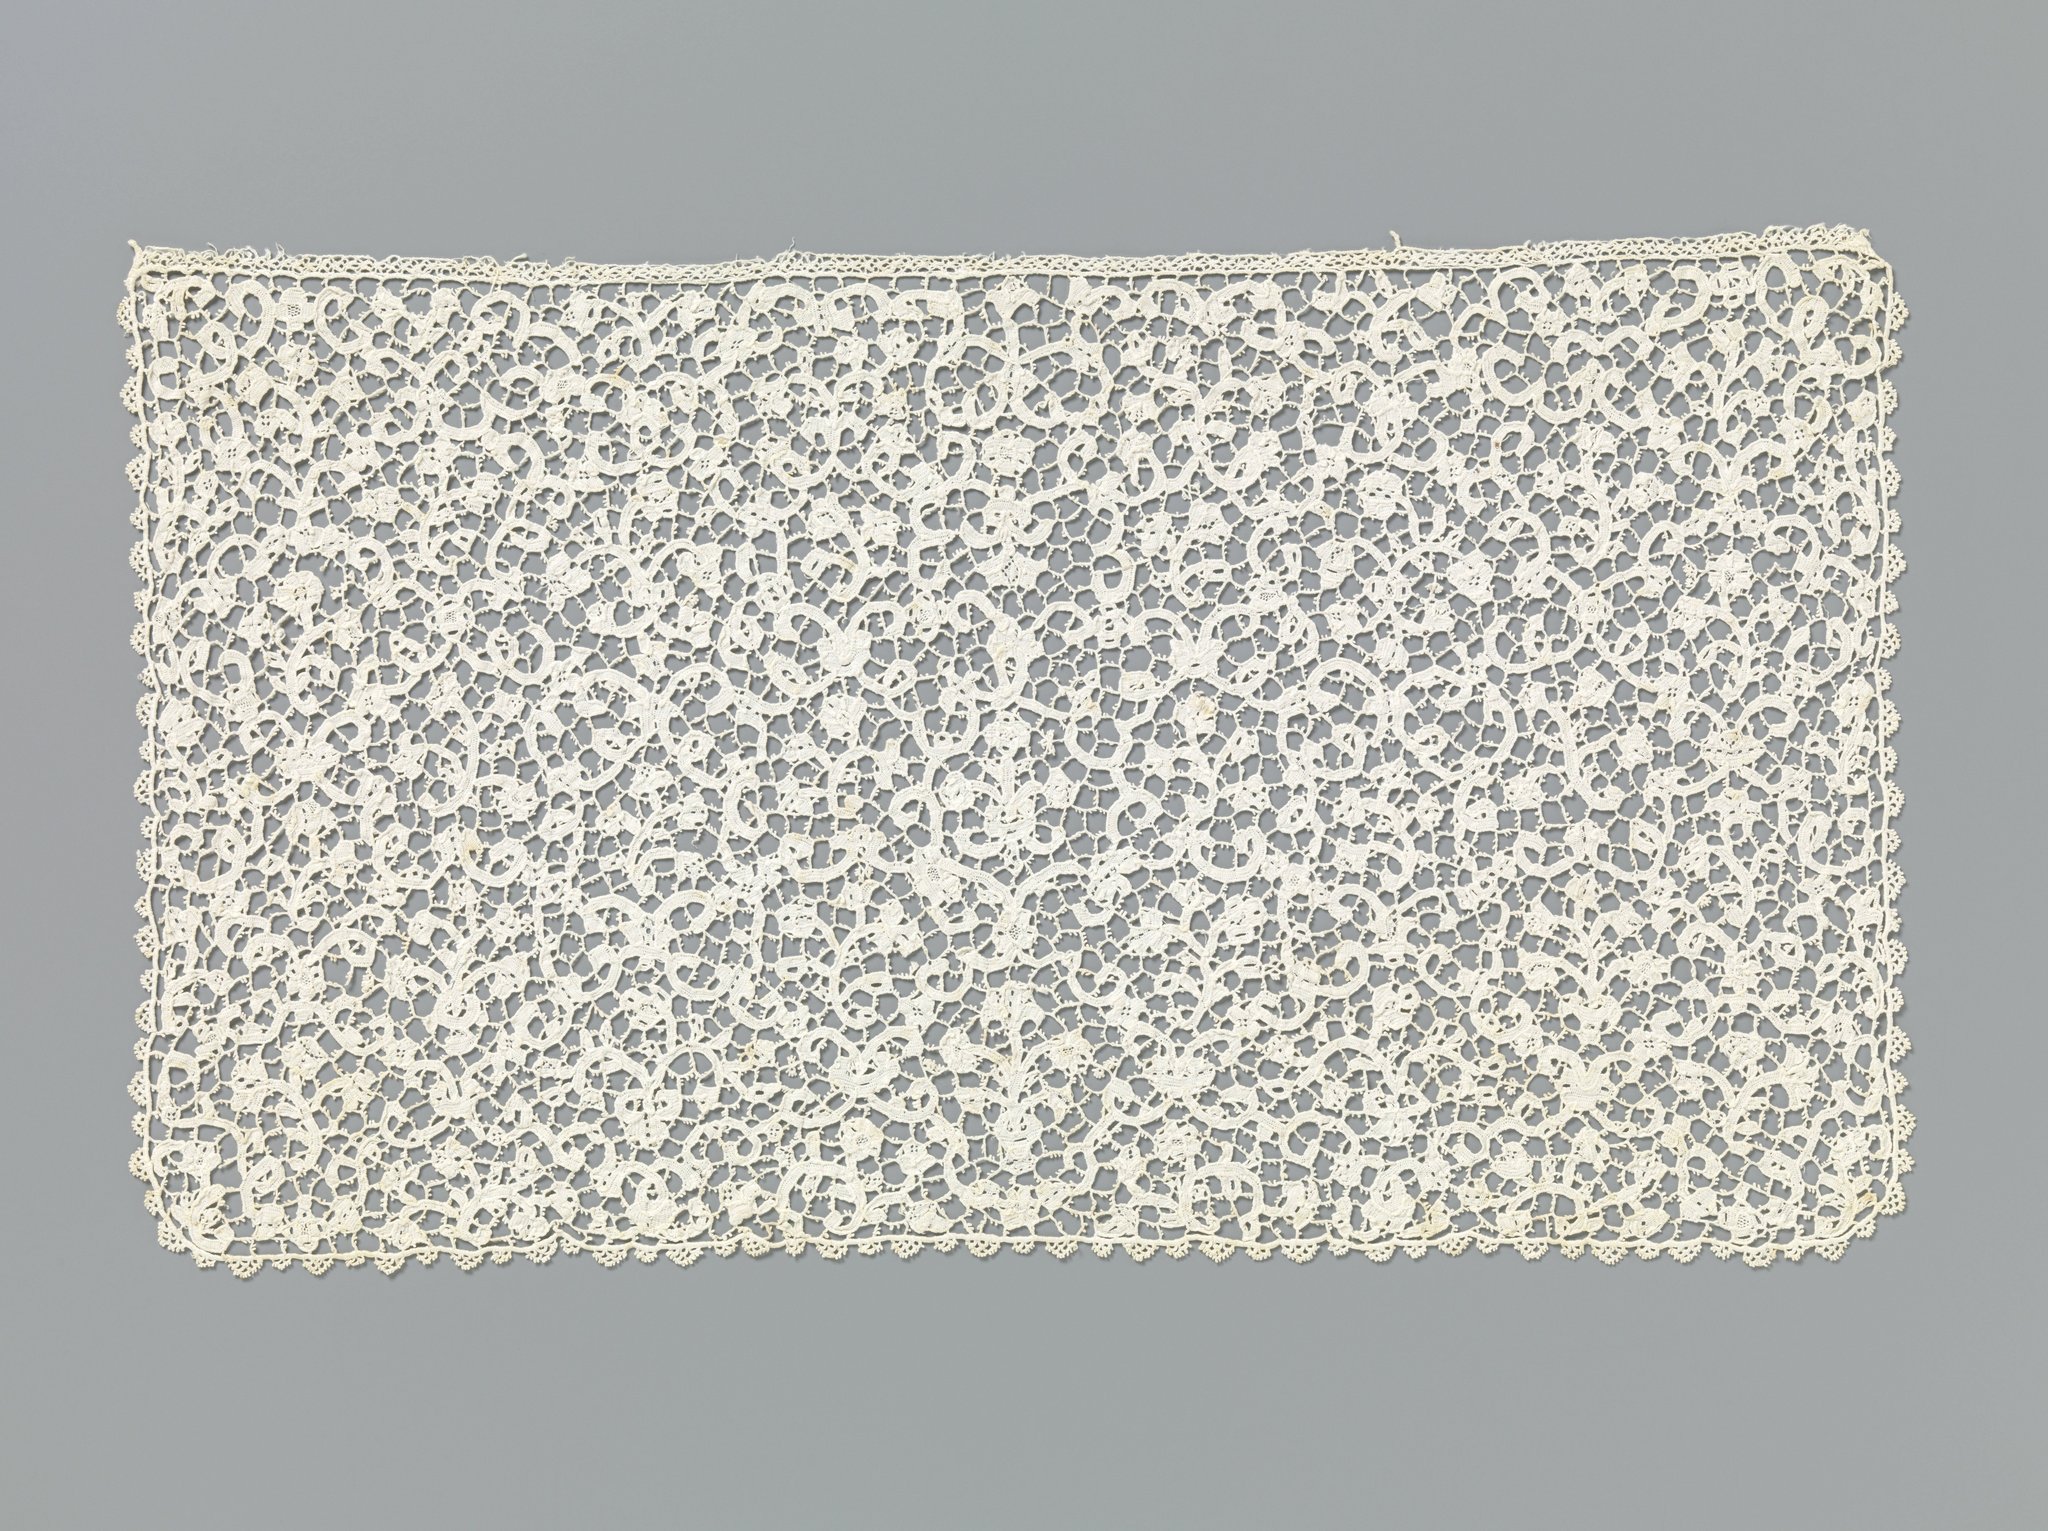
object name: jabot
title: Slip van een jabot van naaldkant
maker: Anonymous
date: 1700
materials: linen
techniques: flat venetian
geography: europe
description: Deze slip vormt samen met bijbehorende slip een jabot: een geplooide strook aan de borst van een mans(over)hemd. [bron: Woordenboek der Nederlandse taal] Het type jabot dat deze twee kanten slippen vormen wordt ook wel 'Steinkerque' genoemd: een kanten das, die werd gedragen rond 1700. De das is genoemd naar de plaats van een slag die in 1692 plaatsvond in Steenkerke, gelegen in het huidige Henegouwen, België. De slag werd gewonnen door de maarschalk van Luxemburg, aanvoerder van de Franse troepen. Het was een verovering op Willem III van Engeland, aanvoerder van de verenigde troepen uit Spanje, Holland en Duitsland. De slag werd later aan het Franse hof 'la guerre en dentelles', vrij vertaald: de oorlog in kant genoemd. [bron: Coene, J. Kantlexicon]